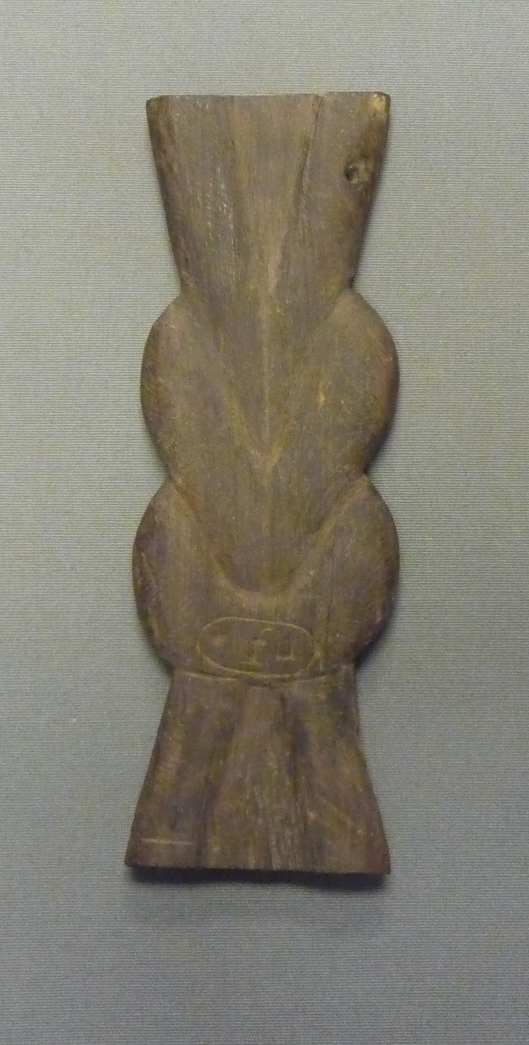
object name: amulet, tjes knot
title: Tjes-Knot Amulet from a Foundation Deposit for Hatshepsut's Temple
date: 1479-1458 BCE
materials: wood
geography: egypt